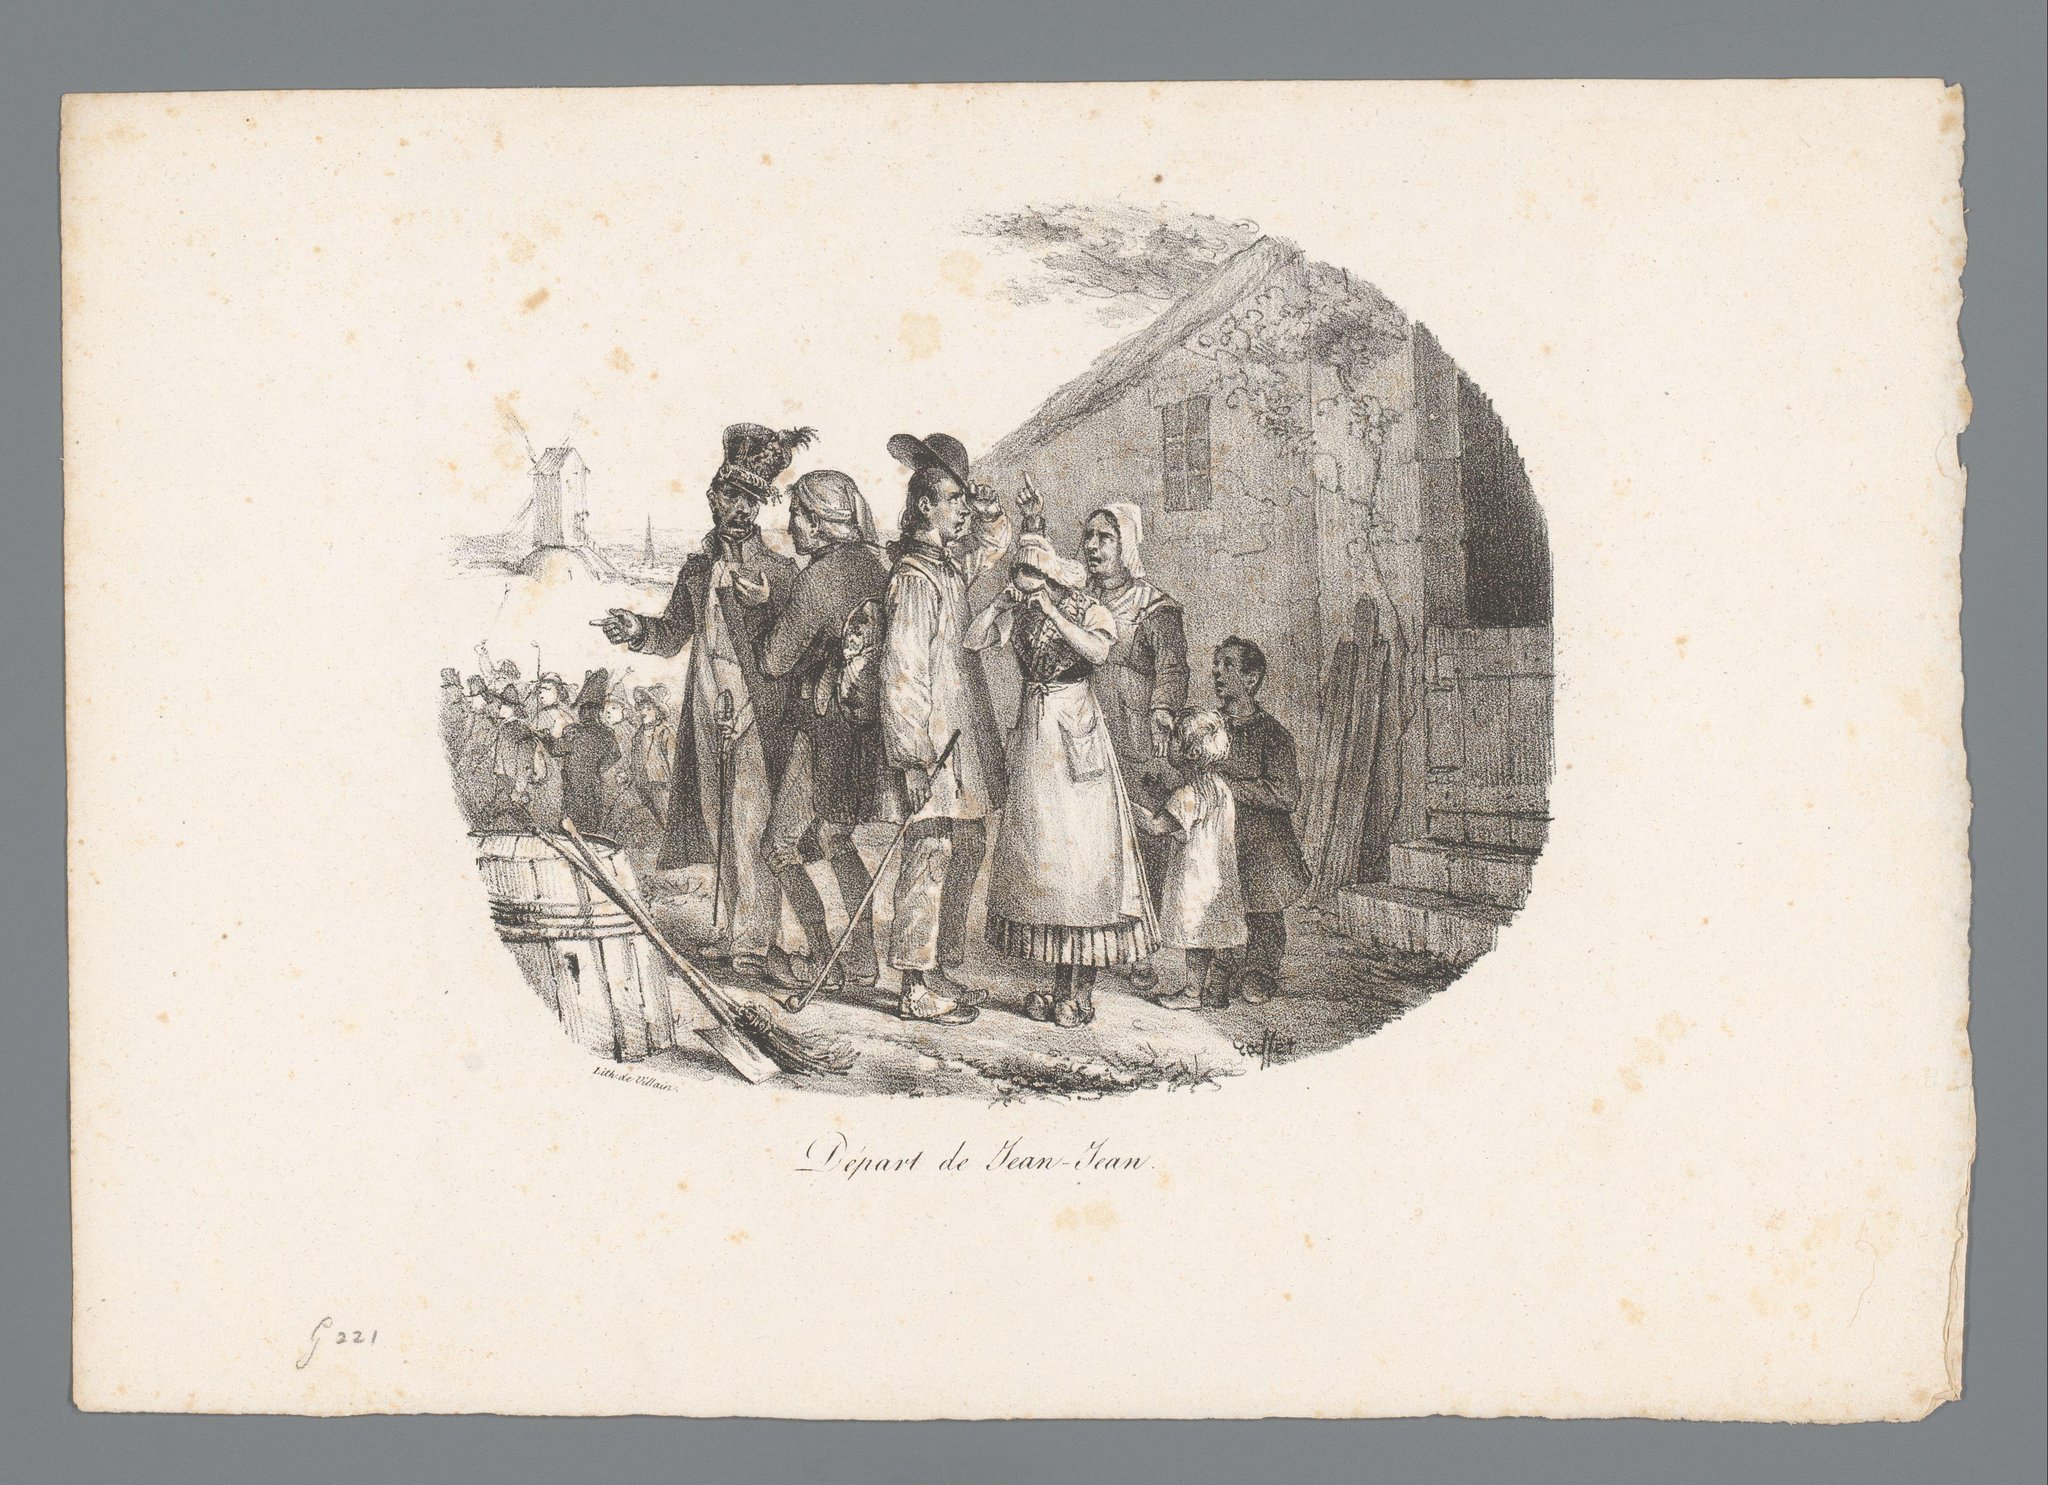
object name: print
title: Jean-Jean neemt afscheid van de mensen om hem heen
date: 1825-1829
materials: paper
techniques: lithograph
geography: paris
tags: waving farewell ~ departure on a journey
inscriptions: collector's mark: Lugt 964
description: Serie bestaat uit titelprent en zestien prenten. Tweede prent in de serie van zeventien prenten.